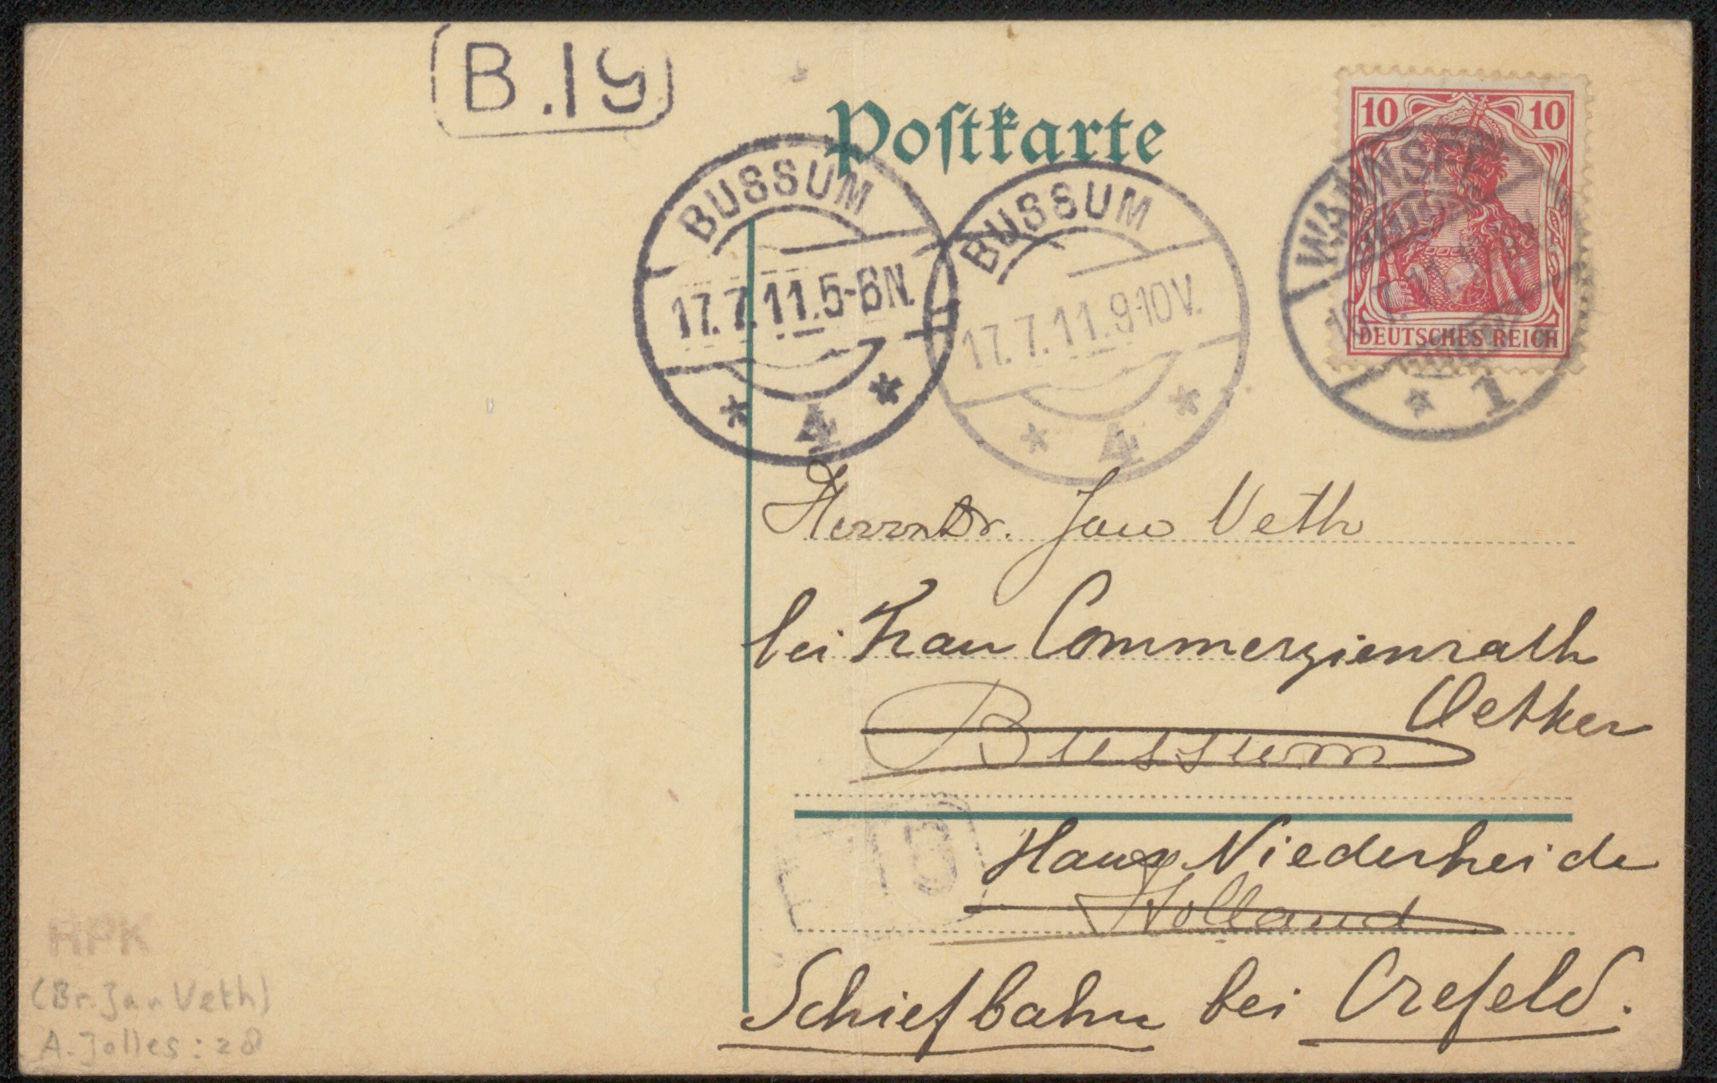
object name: postcard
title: Briefkaart aan Jan Veth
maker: andré jolles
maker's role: journalist, kunsthistoricus, letterkundige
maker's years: 1874-1946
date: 1911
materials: cardboard, ink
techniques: pen, writing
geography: wannsee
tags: dordrecht, amsterdam, painter, print maker, draughtsman, designer, jan veth, holland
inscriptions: collector's mark: ‘RPK’